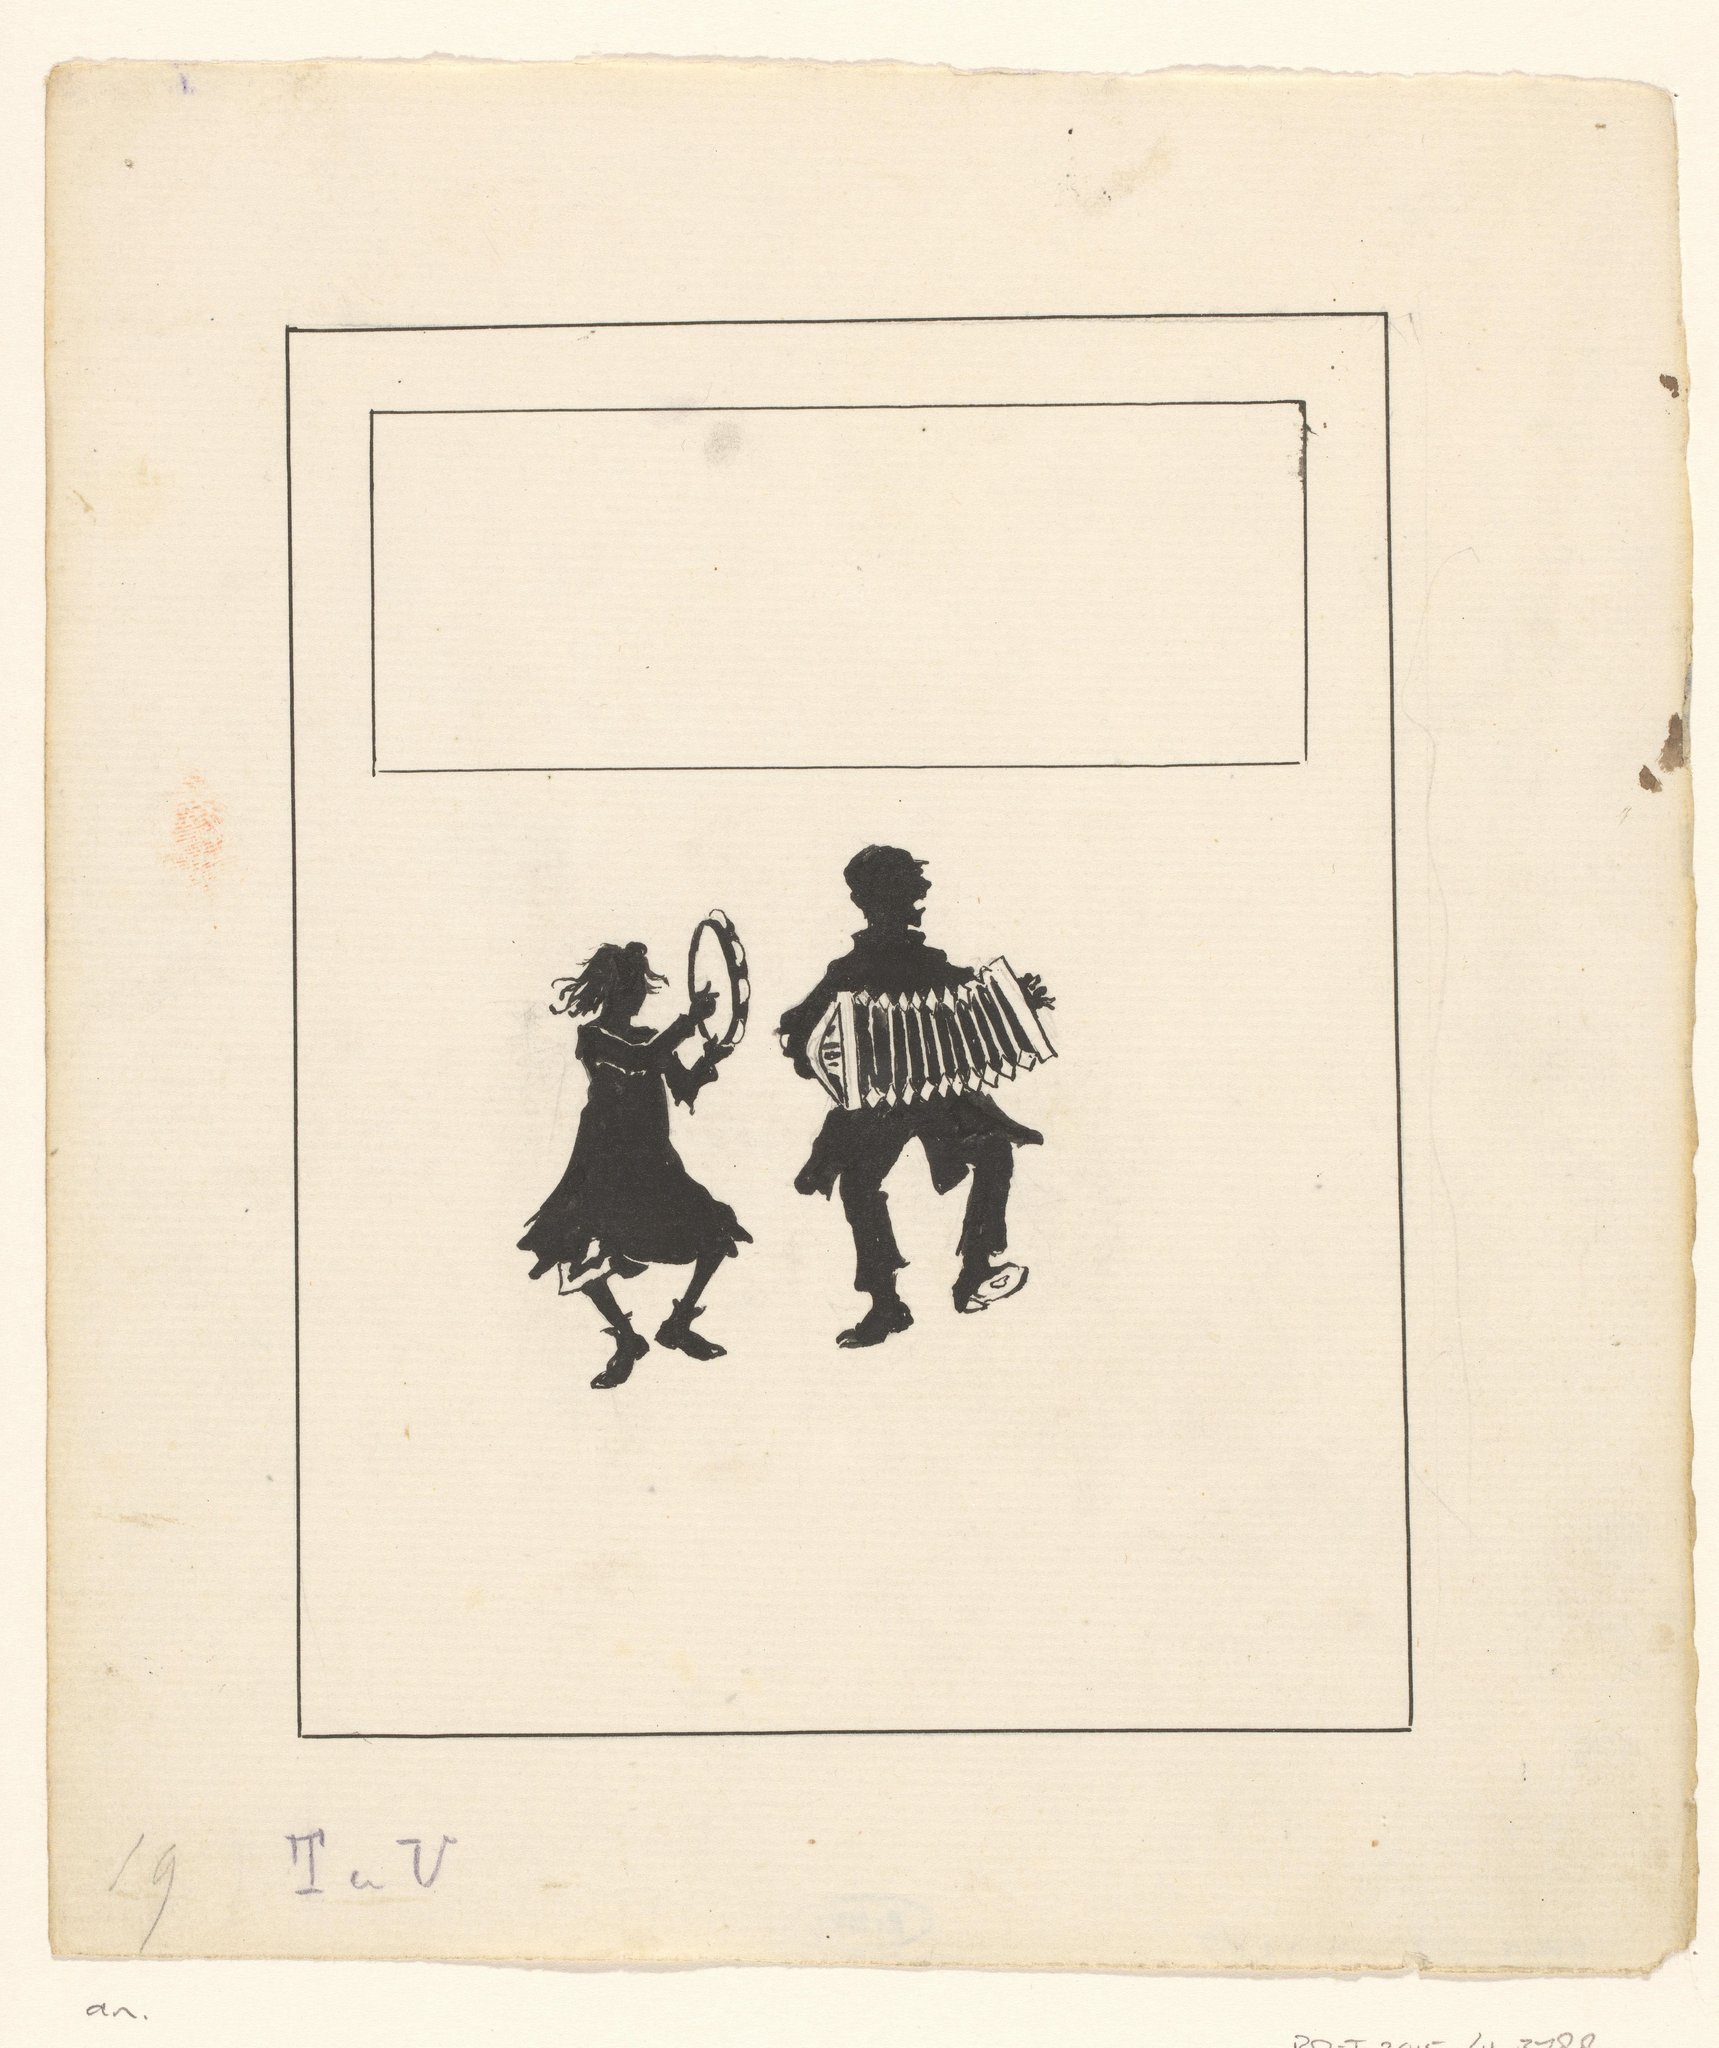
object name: boekillustratie ontwerp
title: Meisje met tamboerijn en jongen met accordeon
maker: Anonymous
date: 1880-1910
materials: ink, paper, pencil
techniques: brush, pen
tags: accordion (+ artist at work), tambourine (+ artist at work)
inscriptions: collector's mark: Lugt 2228a, number: ‘19 T en V’